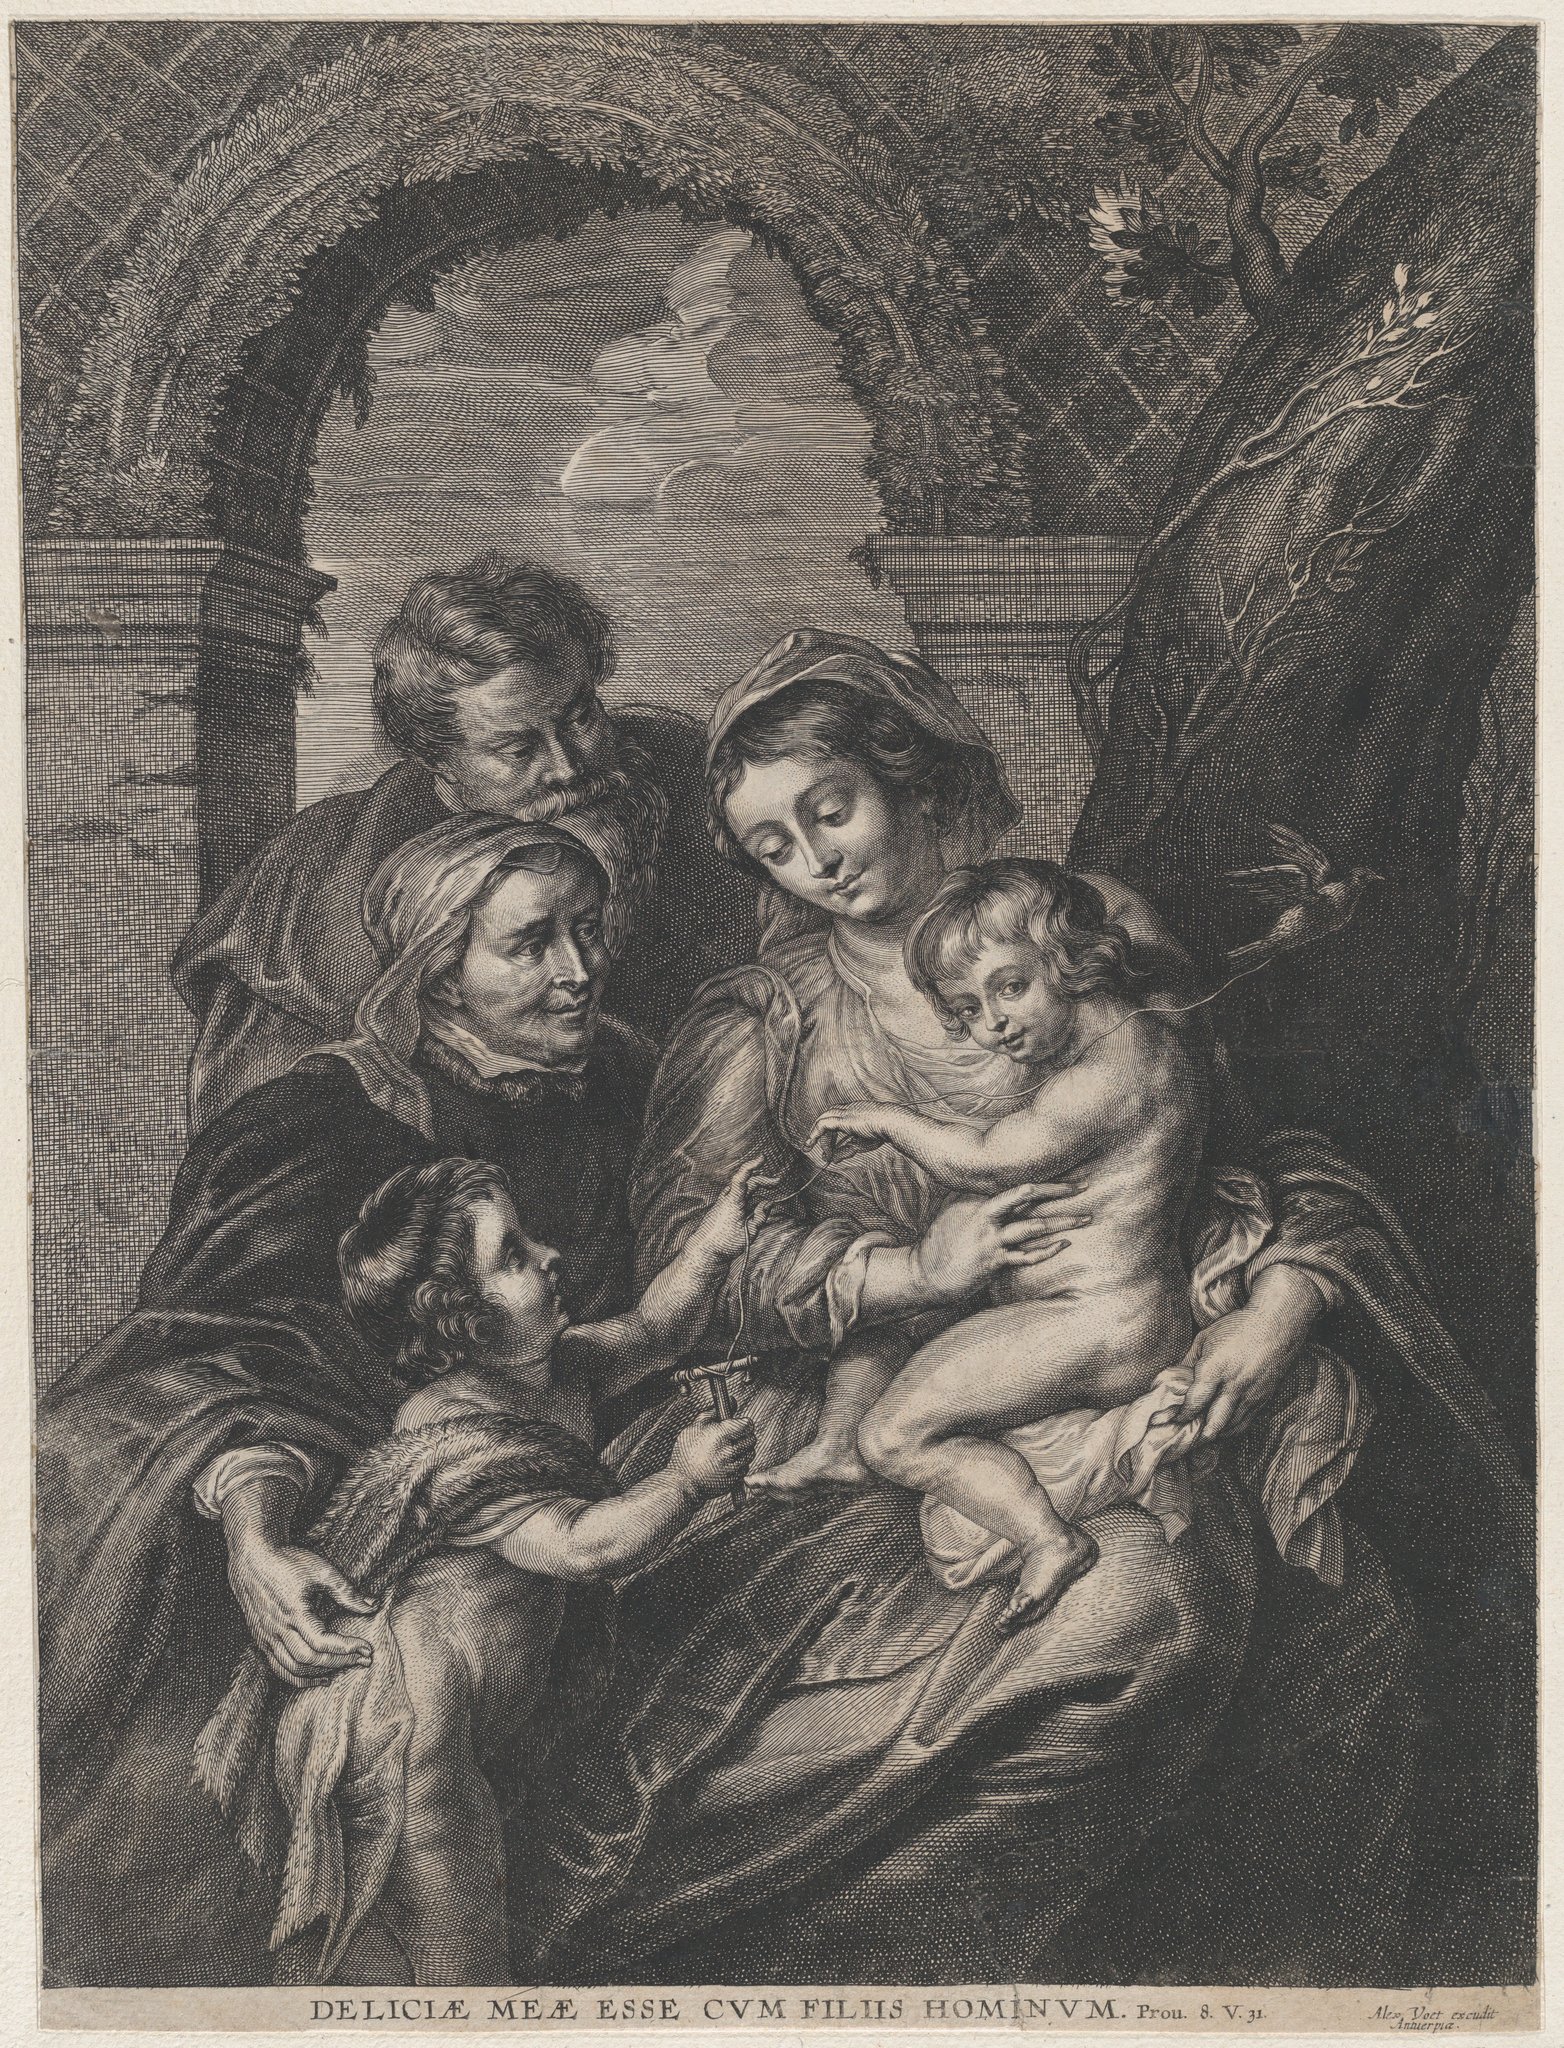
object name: print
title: The Holy Family with Saint Elizabeth and the infant Saint John the Baptist, holding a bird on a string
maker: Anonymous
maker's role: artist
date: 1655-1695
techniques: engraving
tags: holy family,madonna and child,saint john the baptist,saints